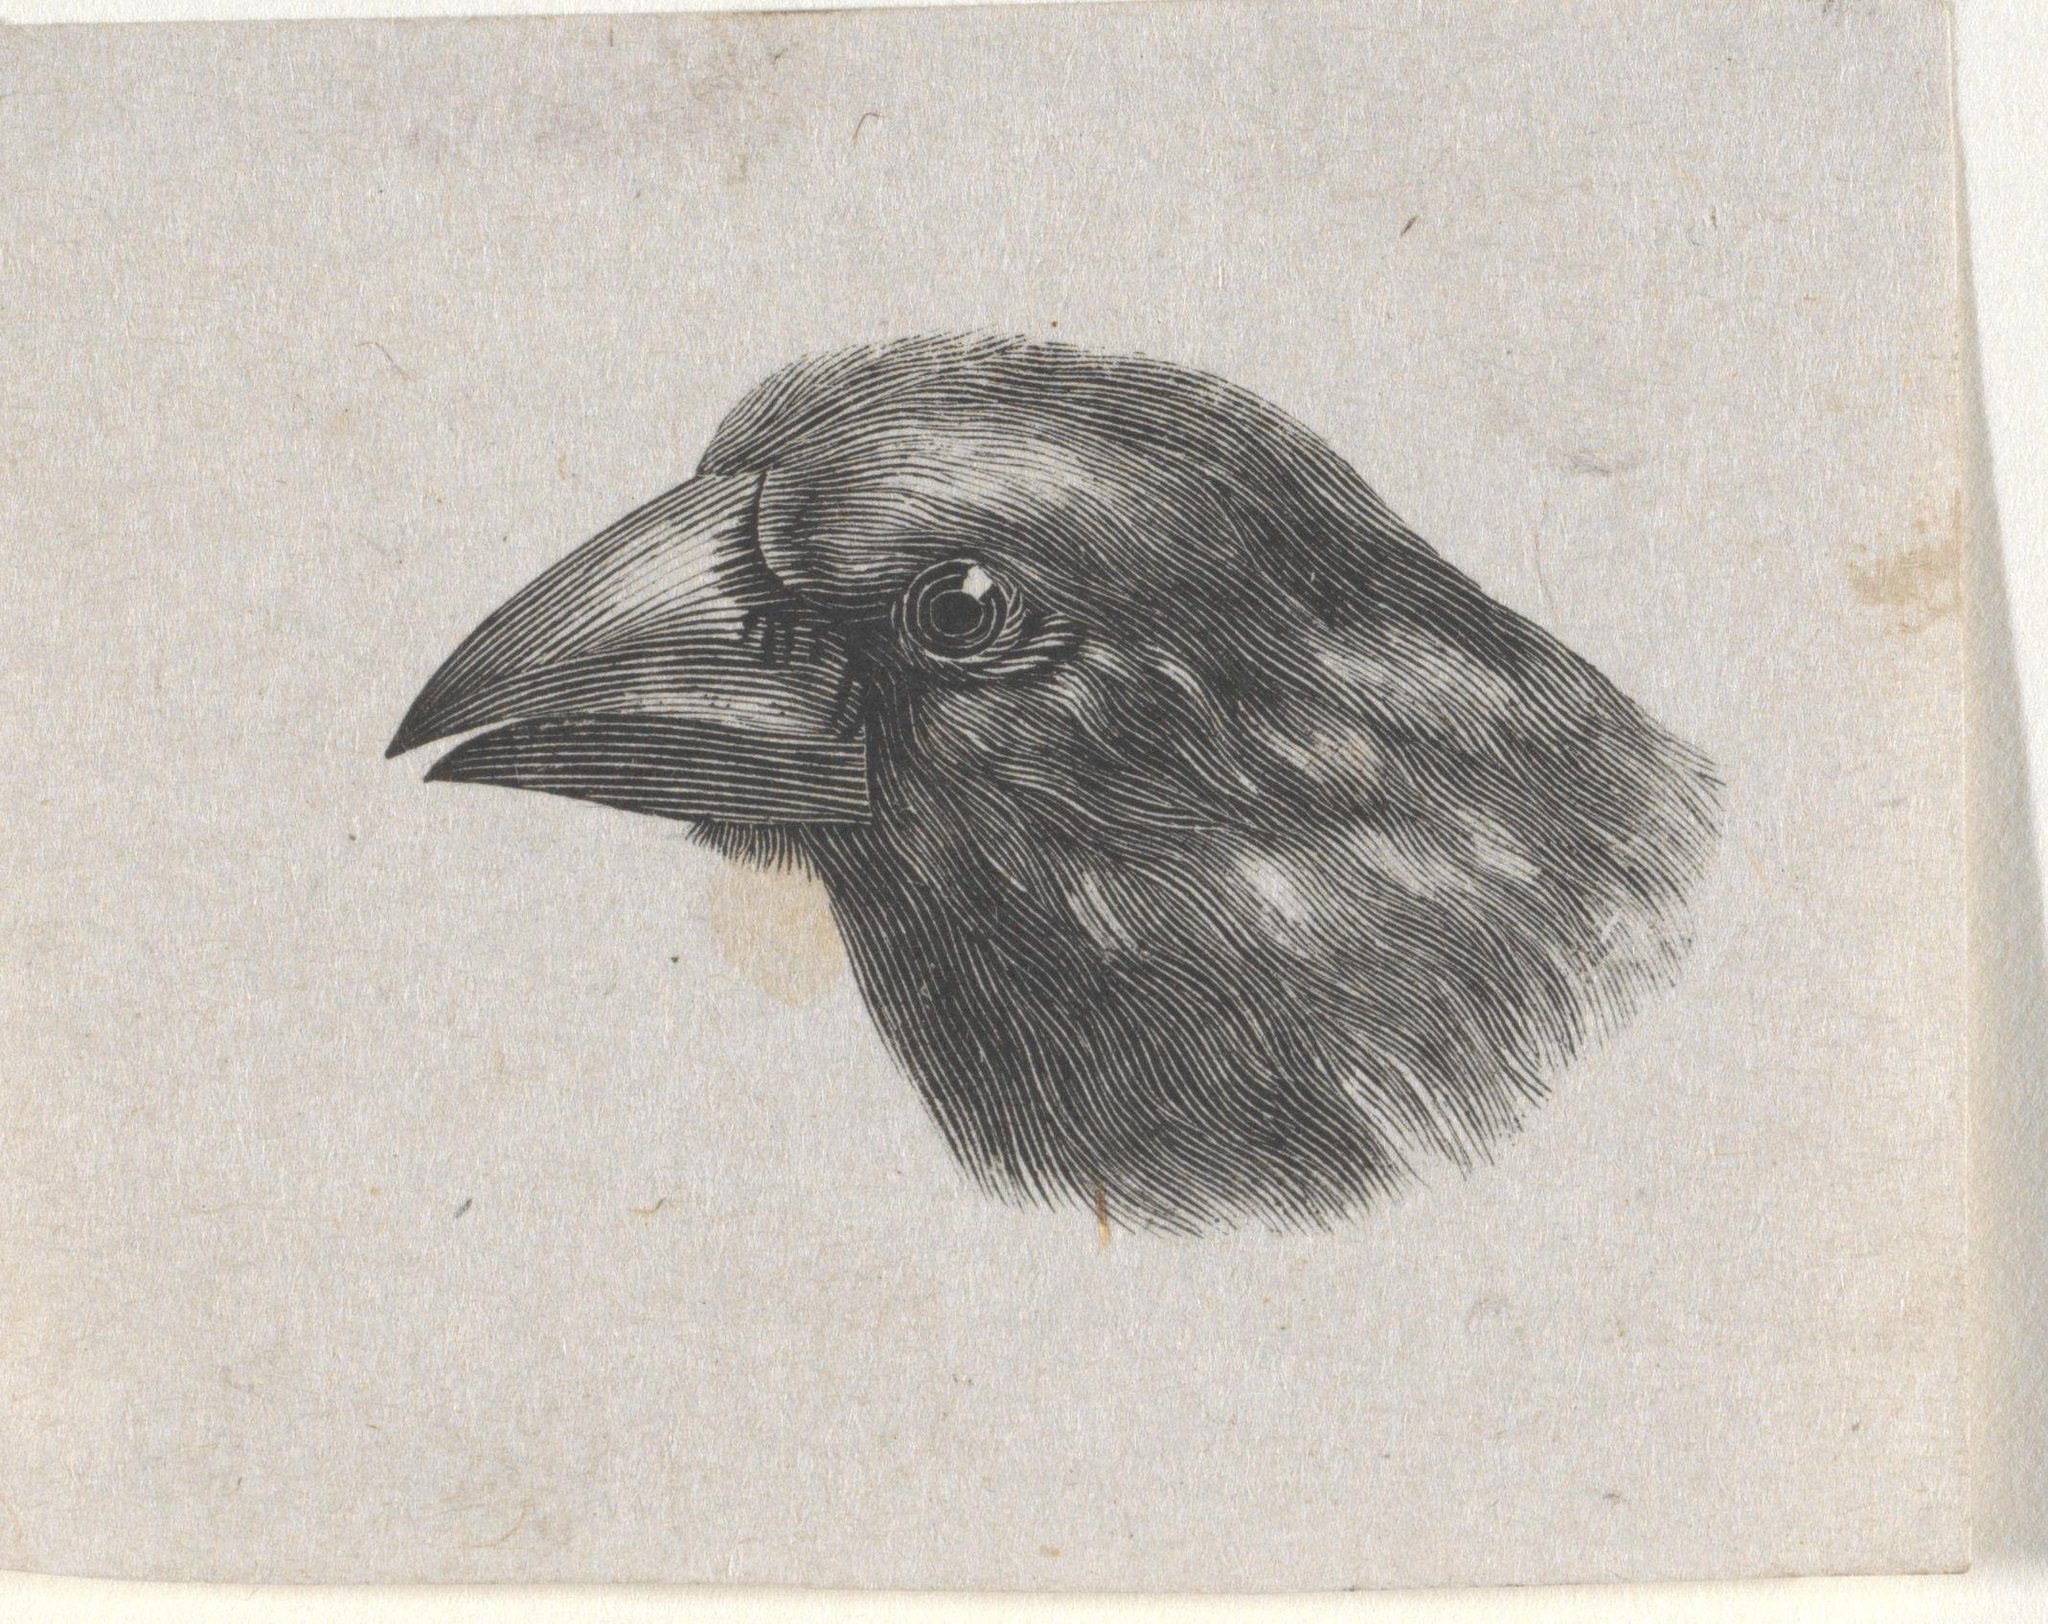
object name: print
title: Vogelkop (mogelijk een groenling of een appelvink)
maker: evert schippers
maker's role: print maker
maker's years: 1846-1935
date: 1856-1935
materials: paper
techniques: engraving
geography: netherlands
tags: birds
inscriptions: collector's mark: Lugt 2228